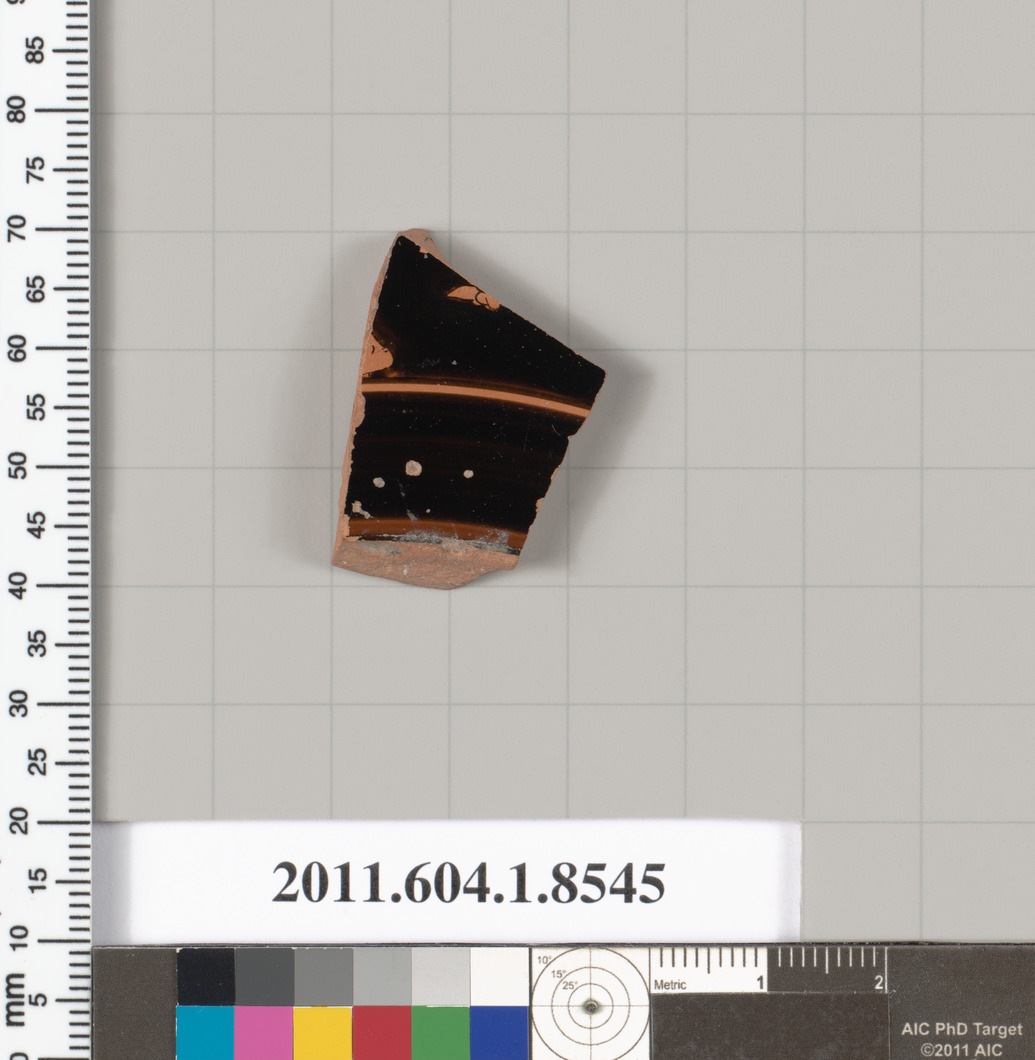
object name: kylix fragment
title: Terracotta fragment of a stemless kylix (drinking cup)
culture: greek, attic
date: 475-451 BCE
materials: terracotta